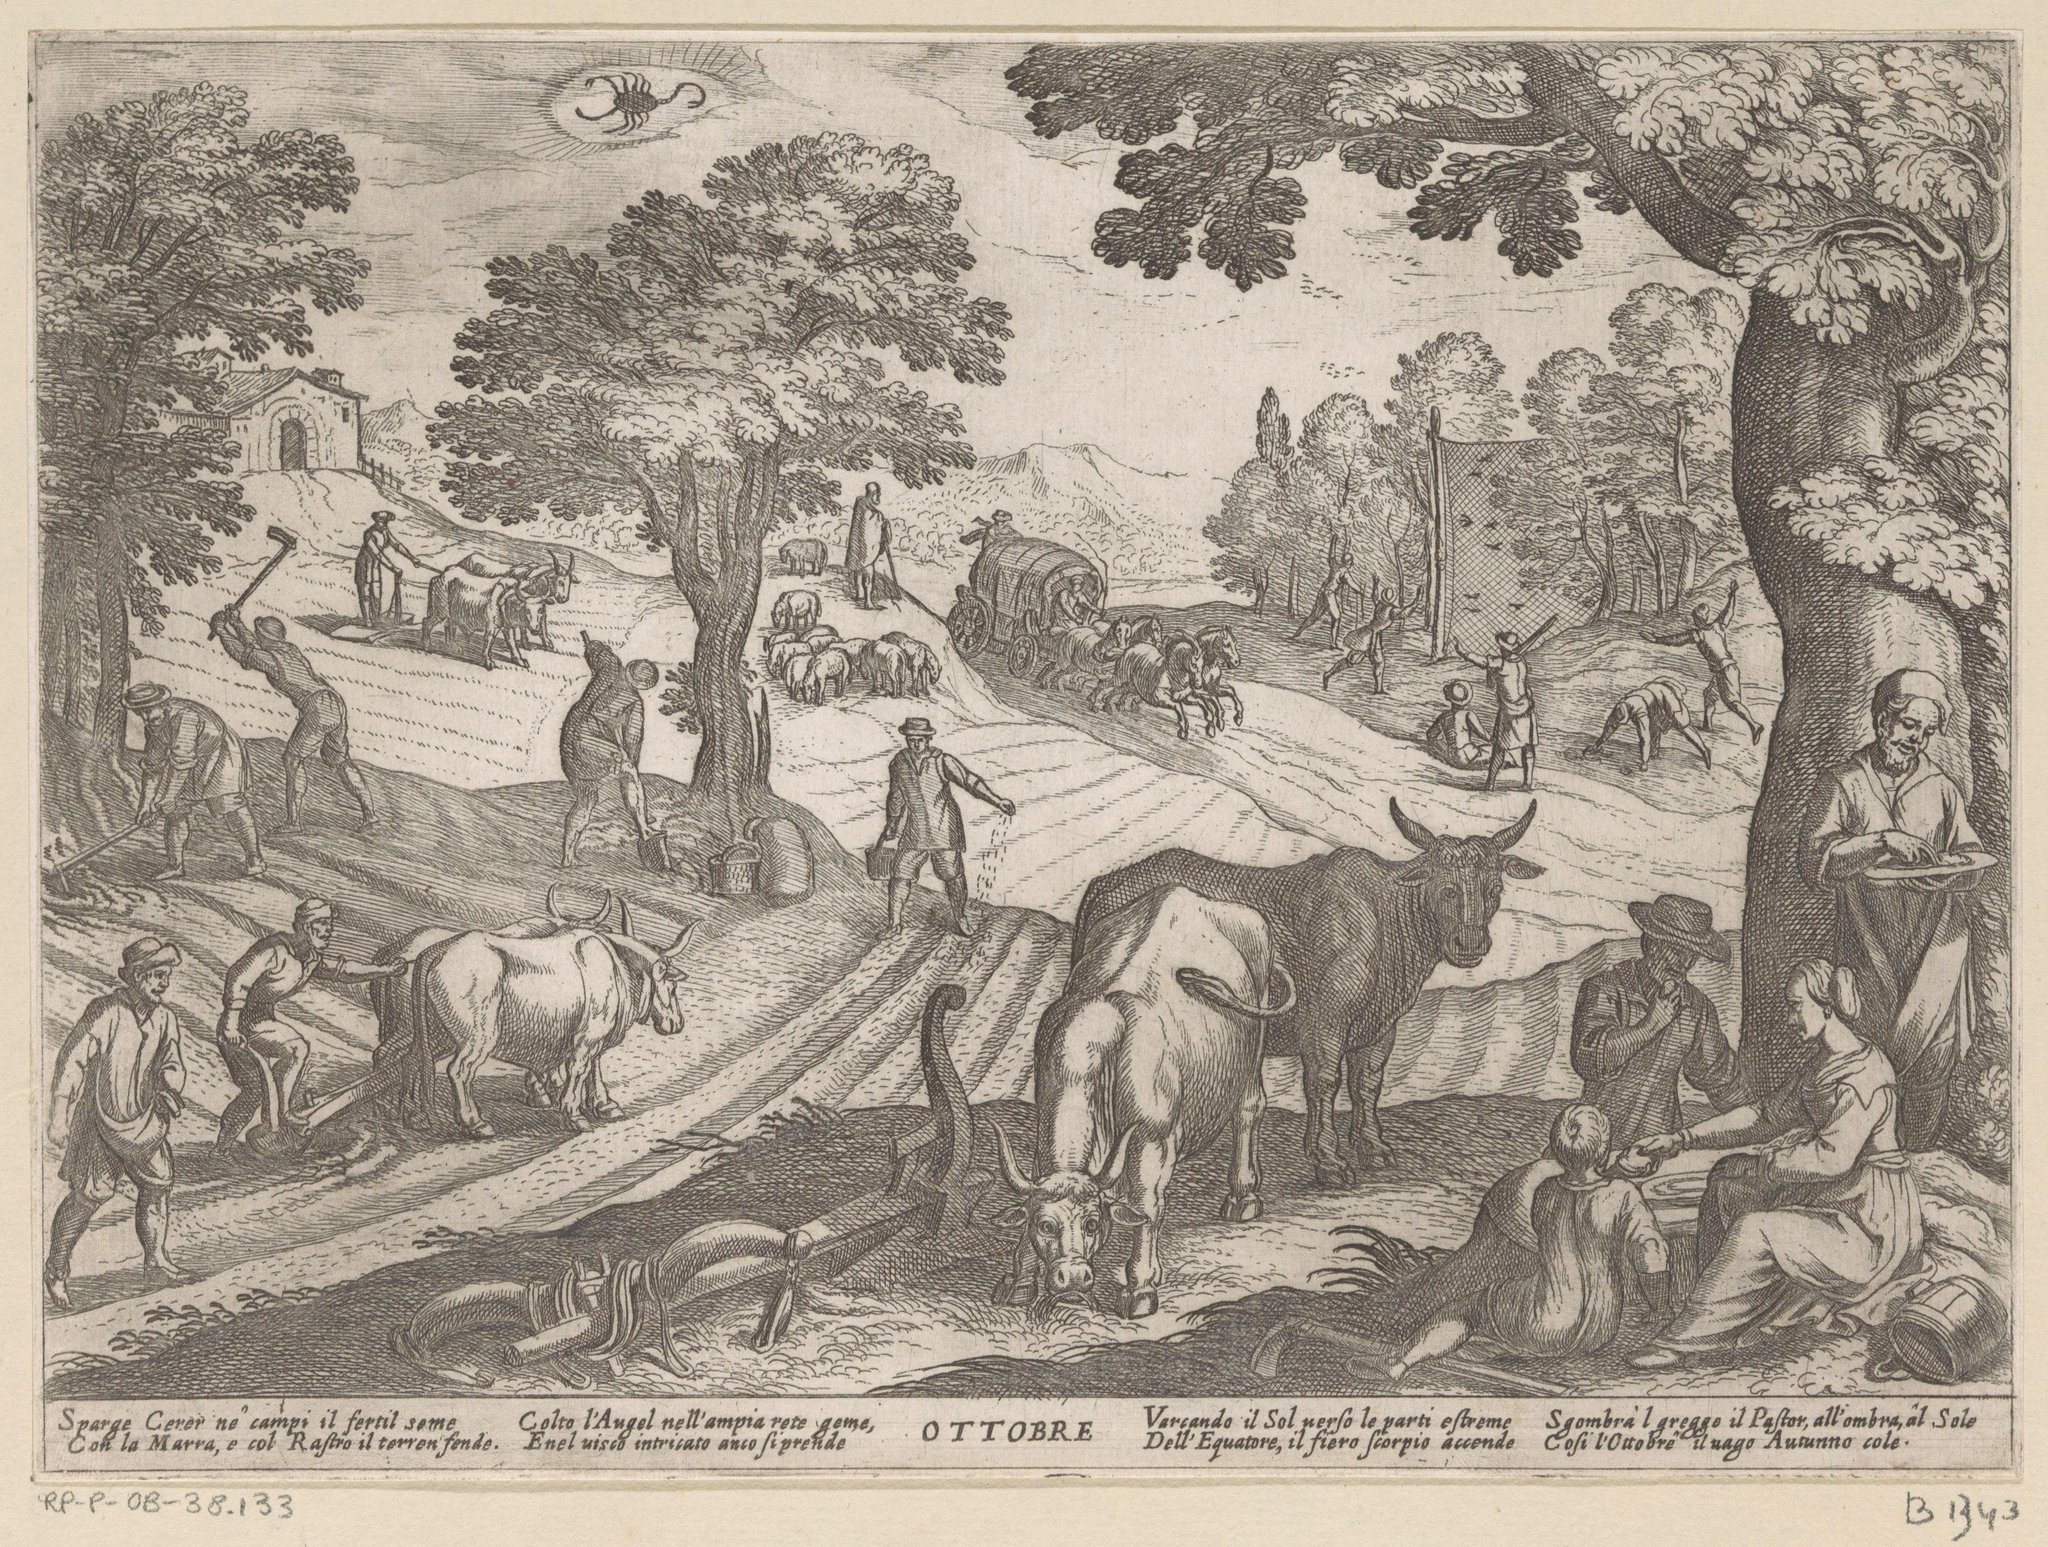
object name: print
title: Ottobre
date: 1599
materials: paper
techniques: etching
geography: rome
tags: the twelve months represented by scenes showing human activities, usually in a landscape; so-called 'labours of the months', farmers, scorpio (zodiacal sign of october), sowing, ploughing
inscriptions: collector's mark: Lugt 240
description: Verbeelding van menselijke activiteit in de maand oktober. Landschap met boeren die zaaien en ploegen. Midden boven het symbool voor het sterrenbeeld schorpioen. Italiaans vers en titel in ondermarge.